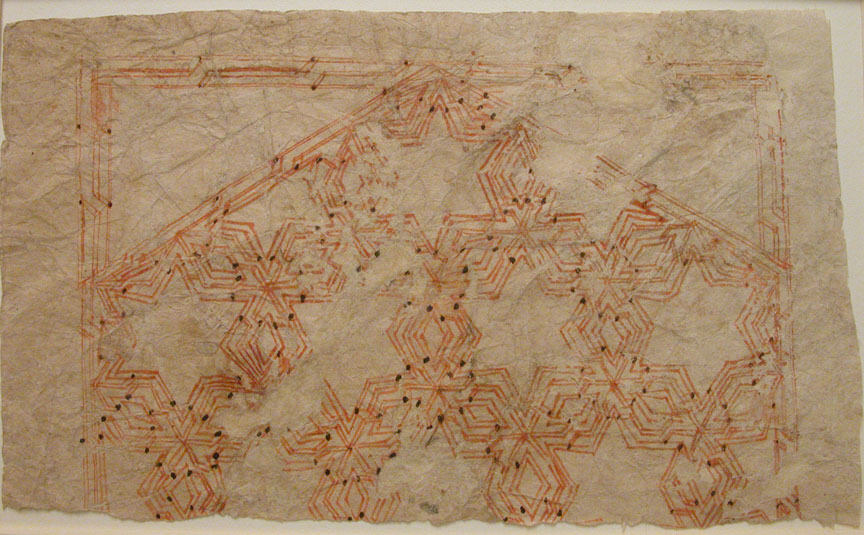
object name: illustrated single work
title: Geometrical Drawing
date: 1251-1300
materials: ink, paper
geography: egypt